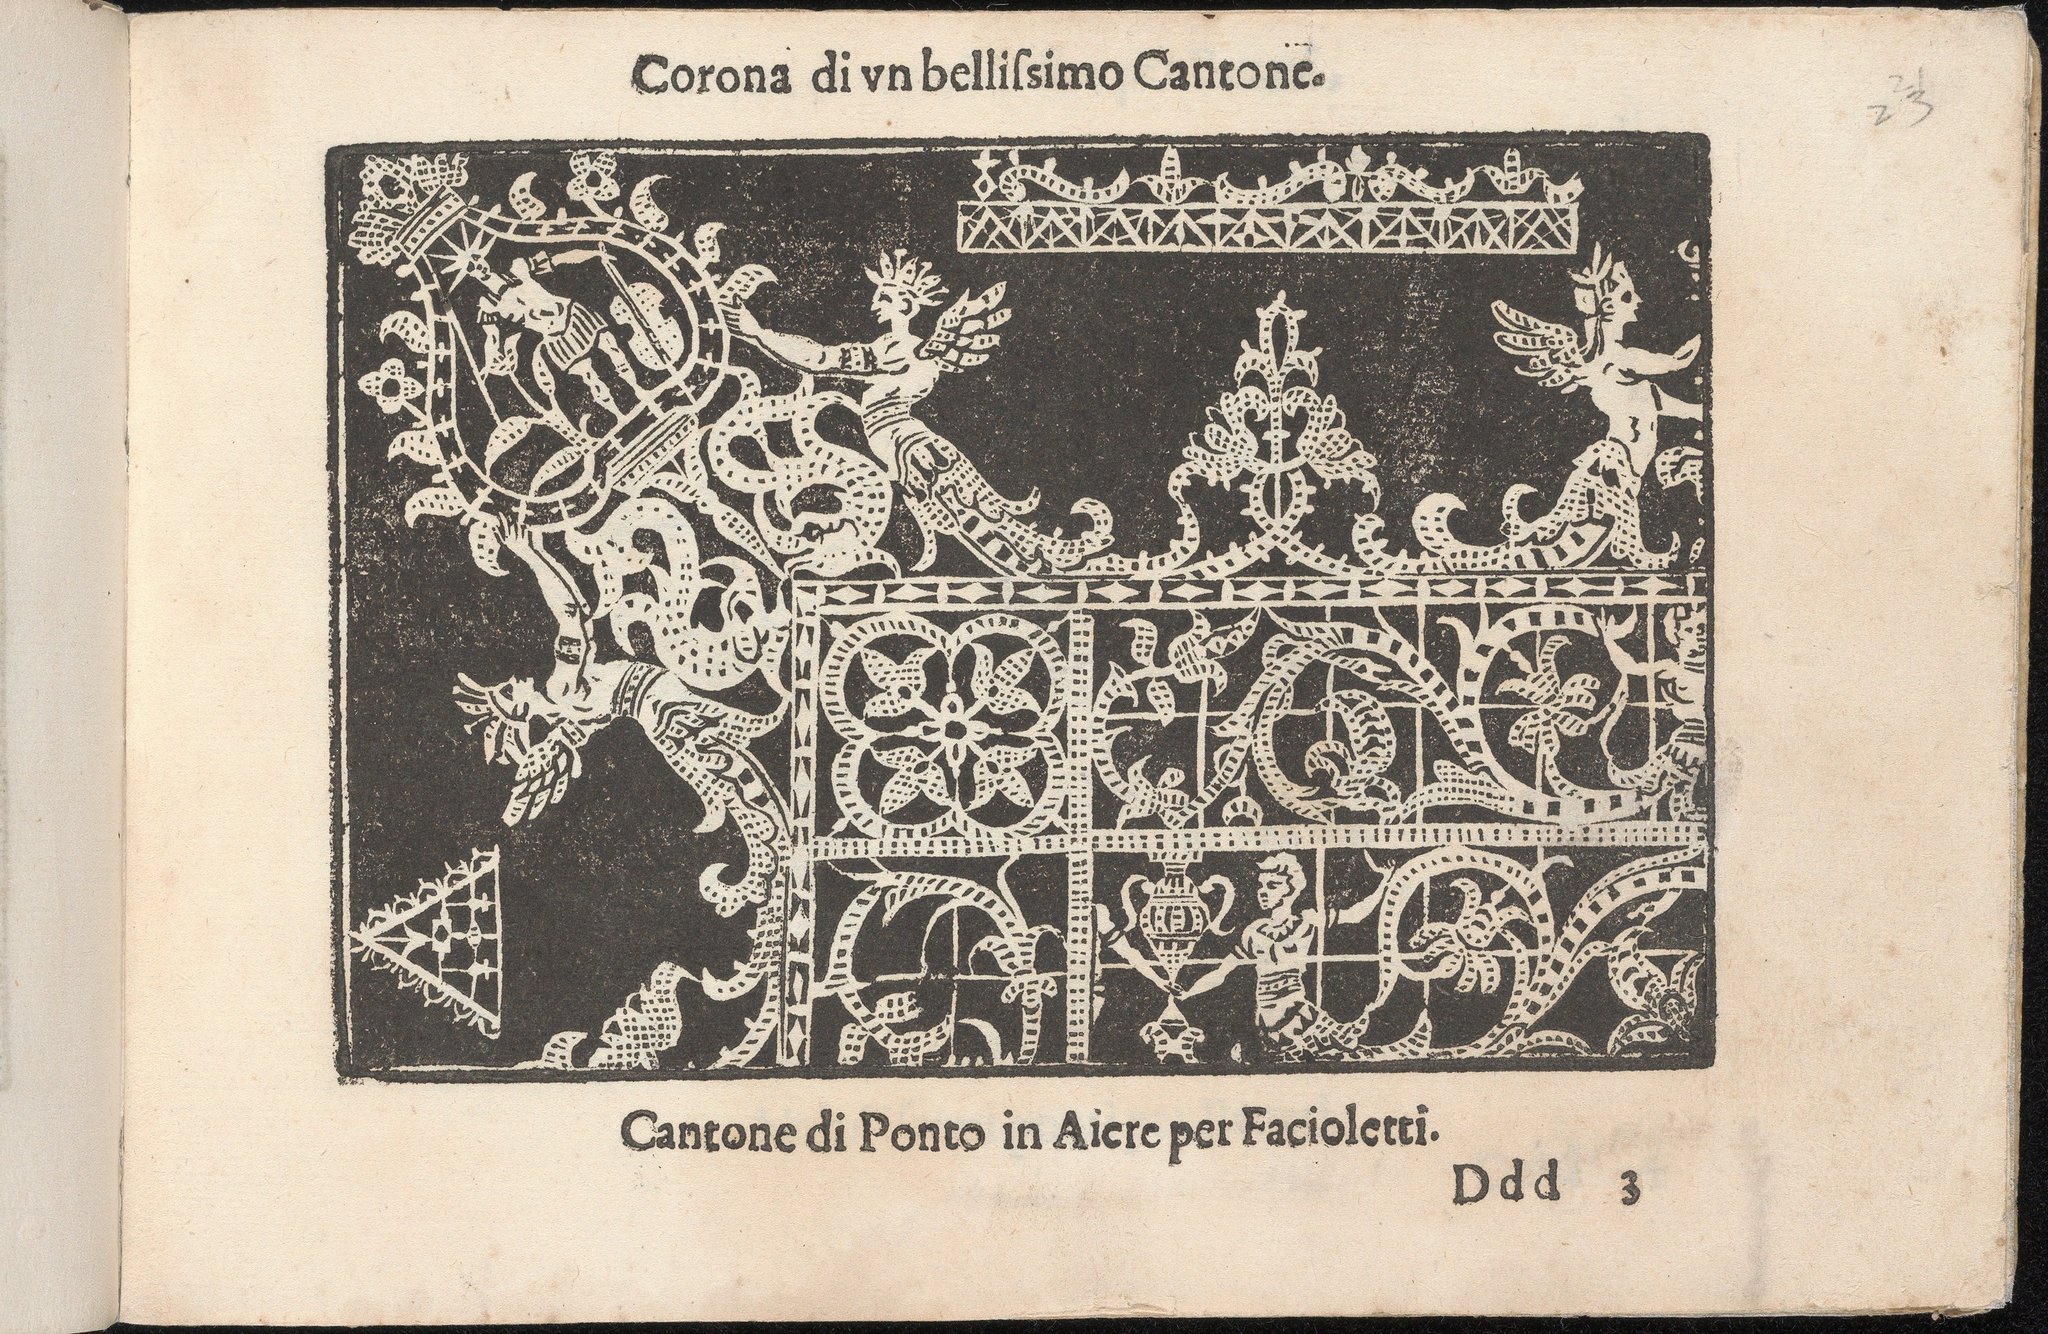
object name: book print ornament architecture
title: Corona delle Nobile et Virtuose Donne, Libro Terzo, page 23 (recto)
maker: cesare vecellio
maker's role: designer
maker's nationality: italian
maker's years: 1521-1601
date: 1620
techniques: woodcut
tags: ornament,flowers